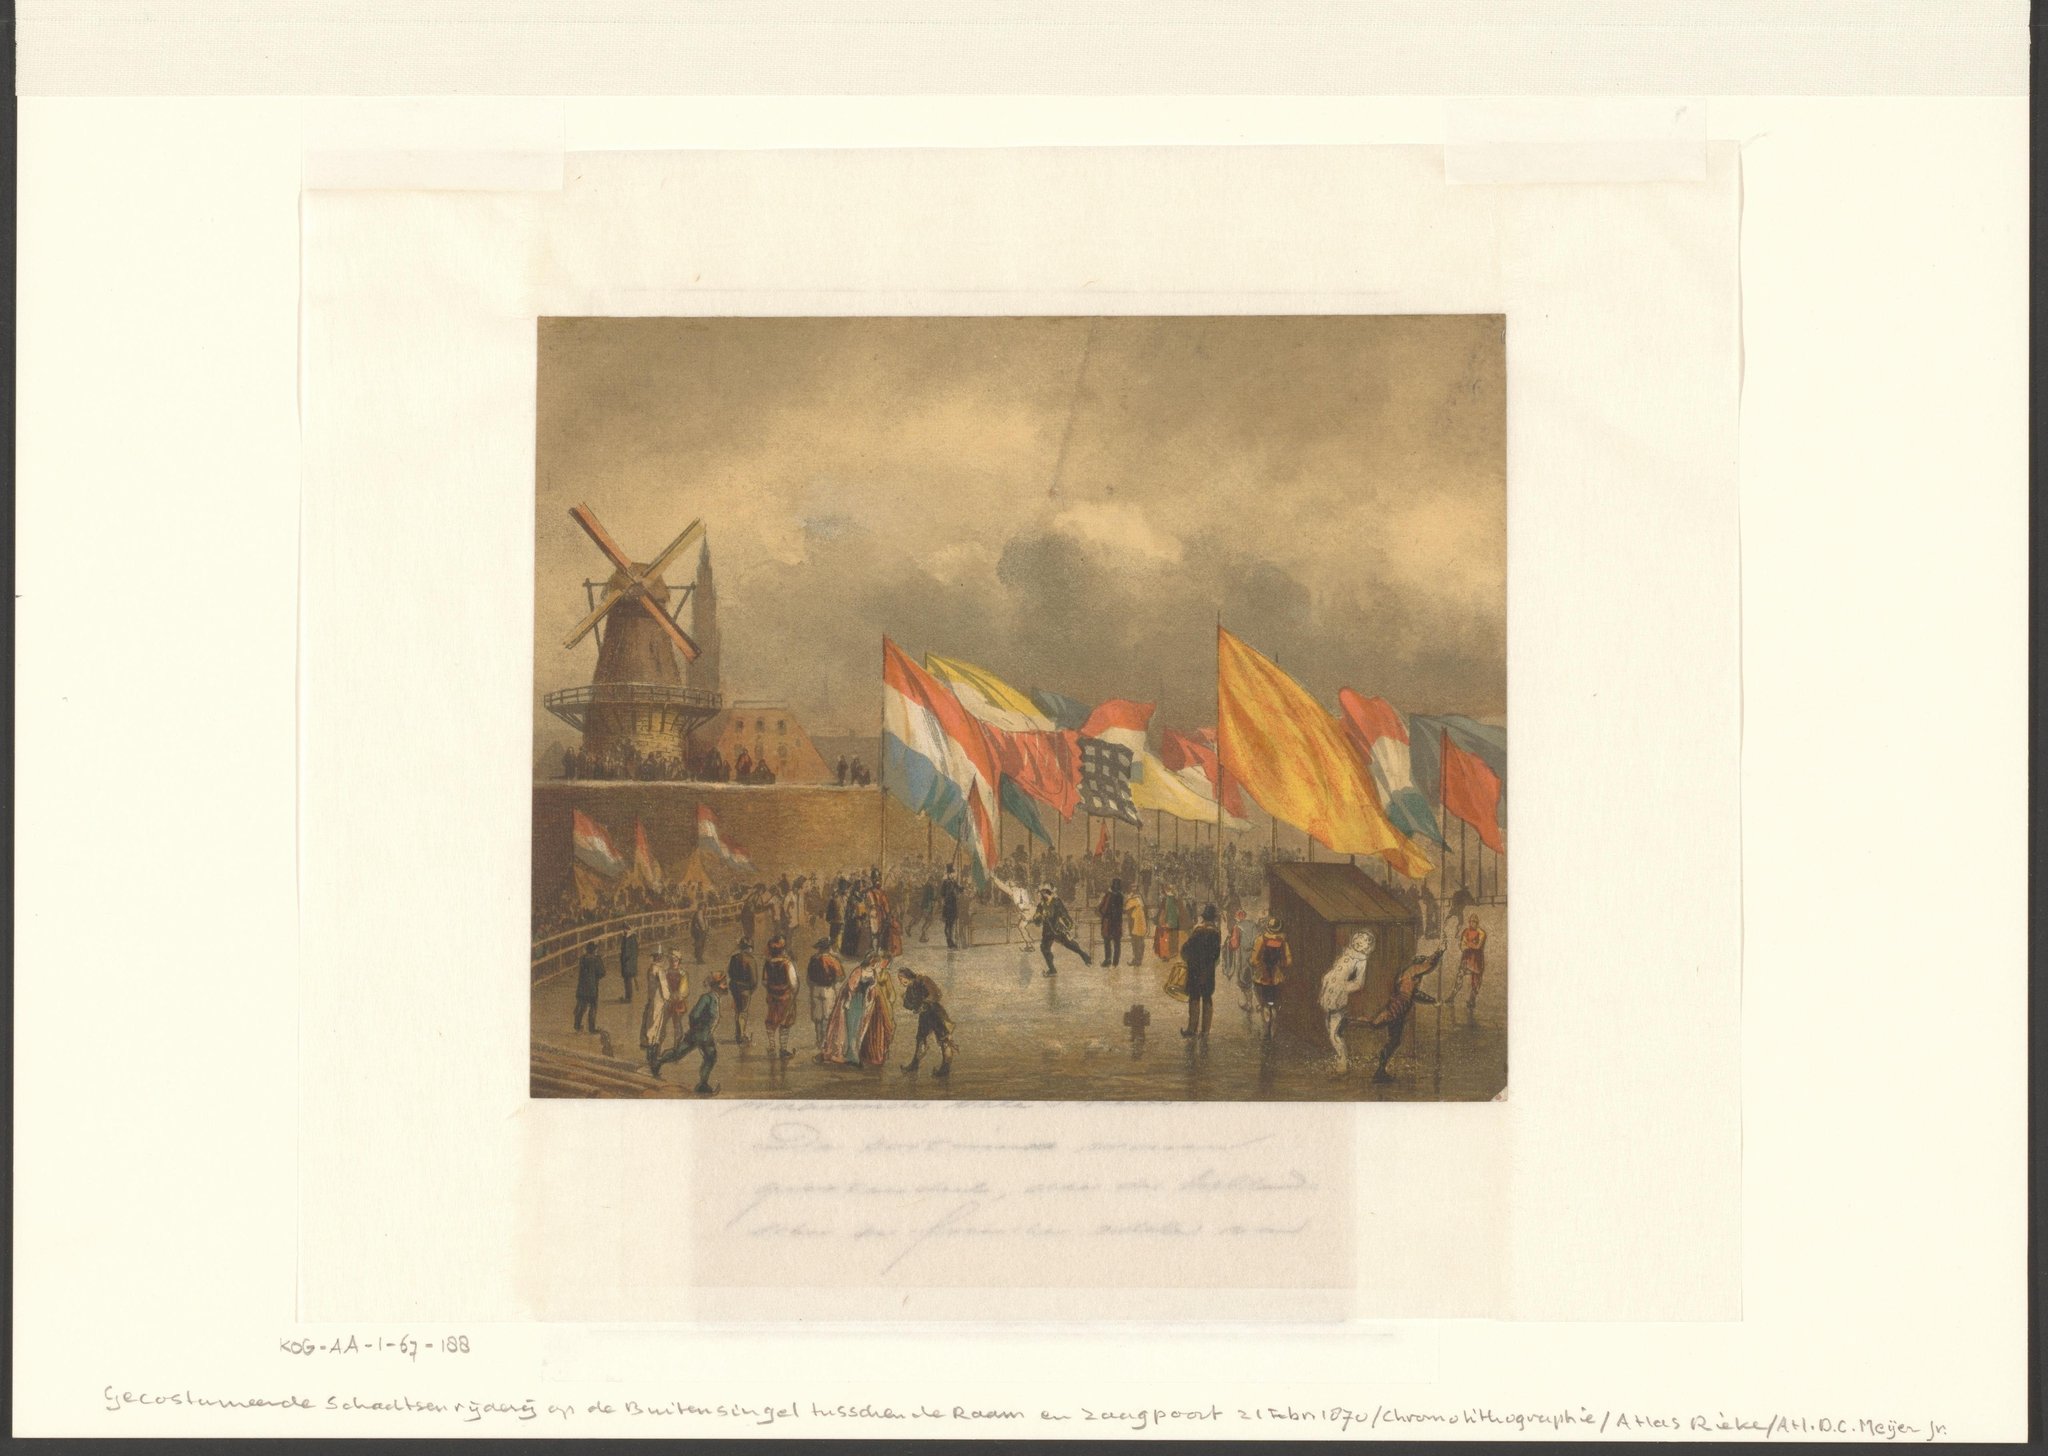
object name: print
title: Gekostumeerd ijsfeest en wedstrijdschaatsen bij bolwerk Slotermeer, 21 februari 1870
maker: Anonymous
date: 1870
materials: paper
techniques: chromolithography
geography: amsterdam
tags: city-view in general; 'veduta', canal, windmill in landscape, skates (winter sports), flag, colours (as symbol of the state, etc.)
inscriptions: inscription: ‘Gecostumeerde schaatsenrijderij op (...) D.C. Meijer jr.’, inscription: ‘Amsterdam 18 Sept (...) Geteekend M.H.Ma[...]ny’, collector's mark: Lugt 2138d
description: Onderwerpsrubriek binnen de Atlas Amsterdam: t/m O. Sport (alfabetisch).